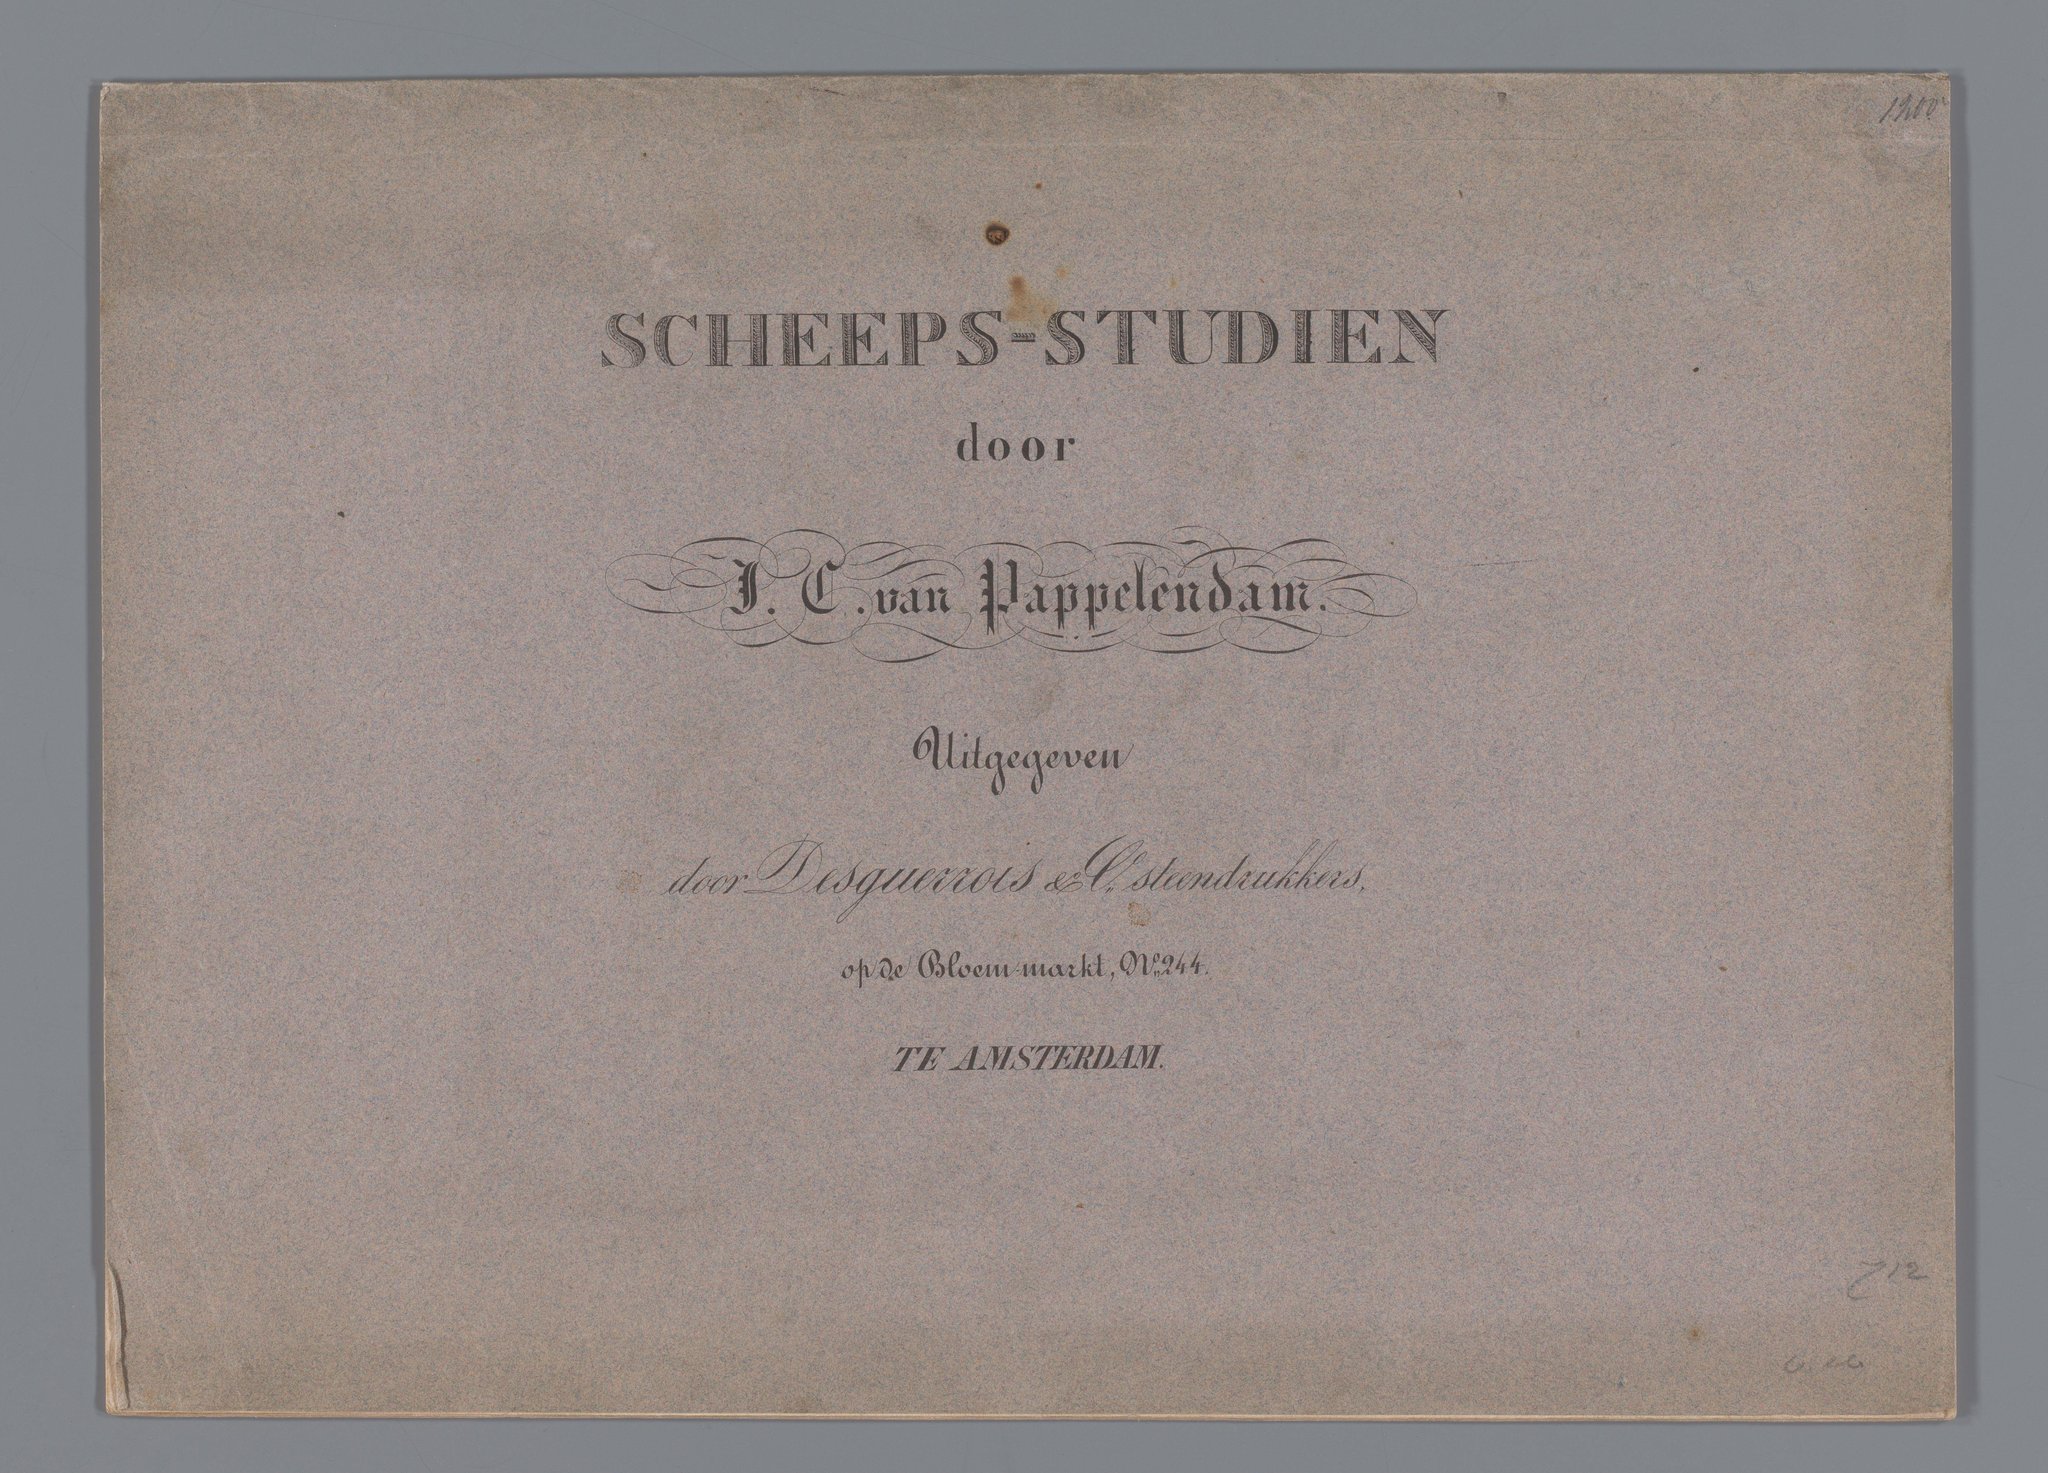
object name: prentrecueil, prentenalbum, prentalbum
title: Scheeps-studien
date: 1827-1884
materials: paper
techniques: lithograph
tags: ships (in general)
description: Prentalbum met een serie van vier lithografieën van schepen van Johannes Cornelis van Pappelendam. Schrift met grijze omslag waarin lithografieën gebonden.